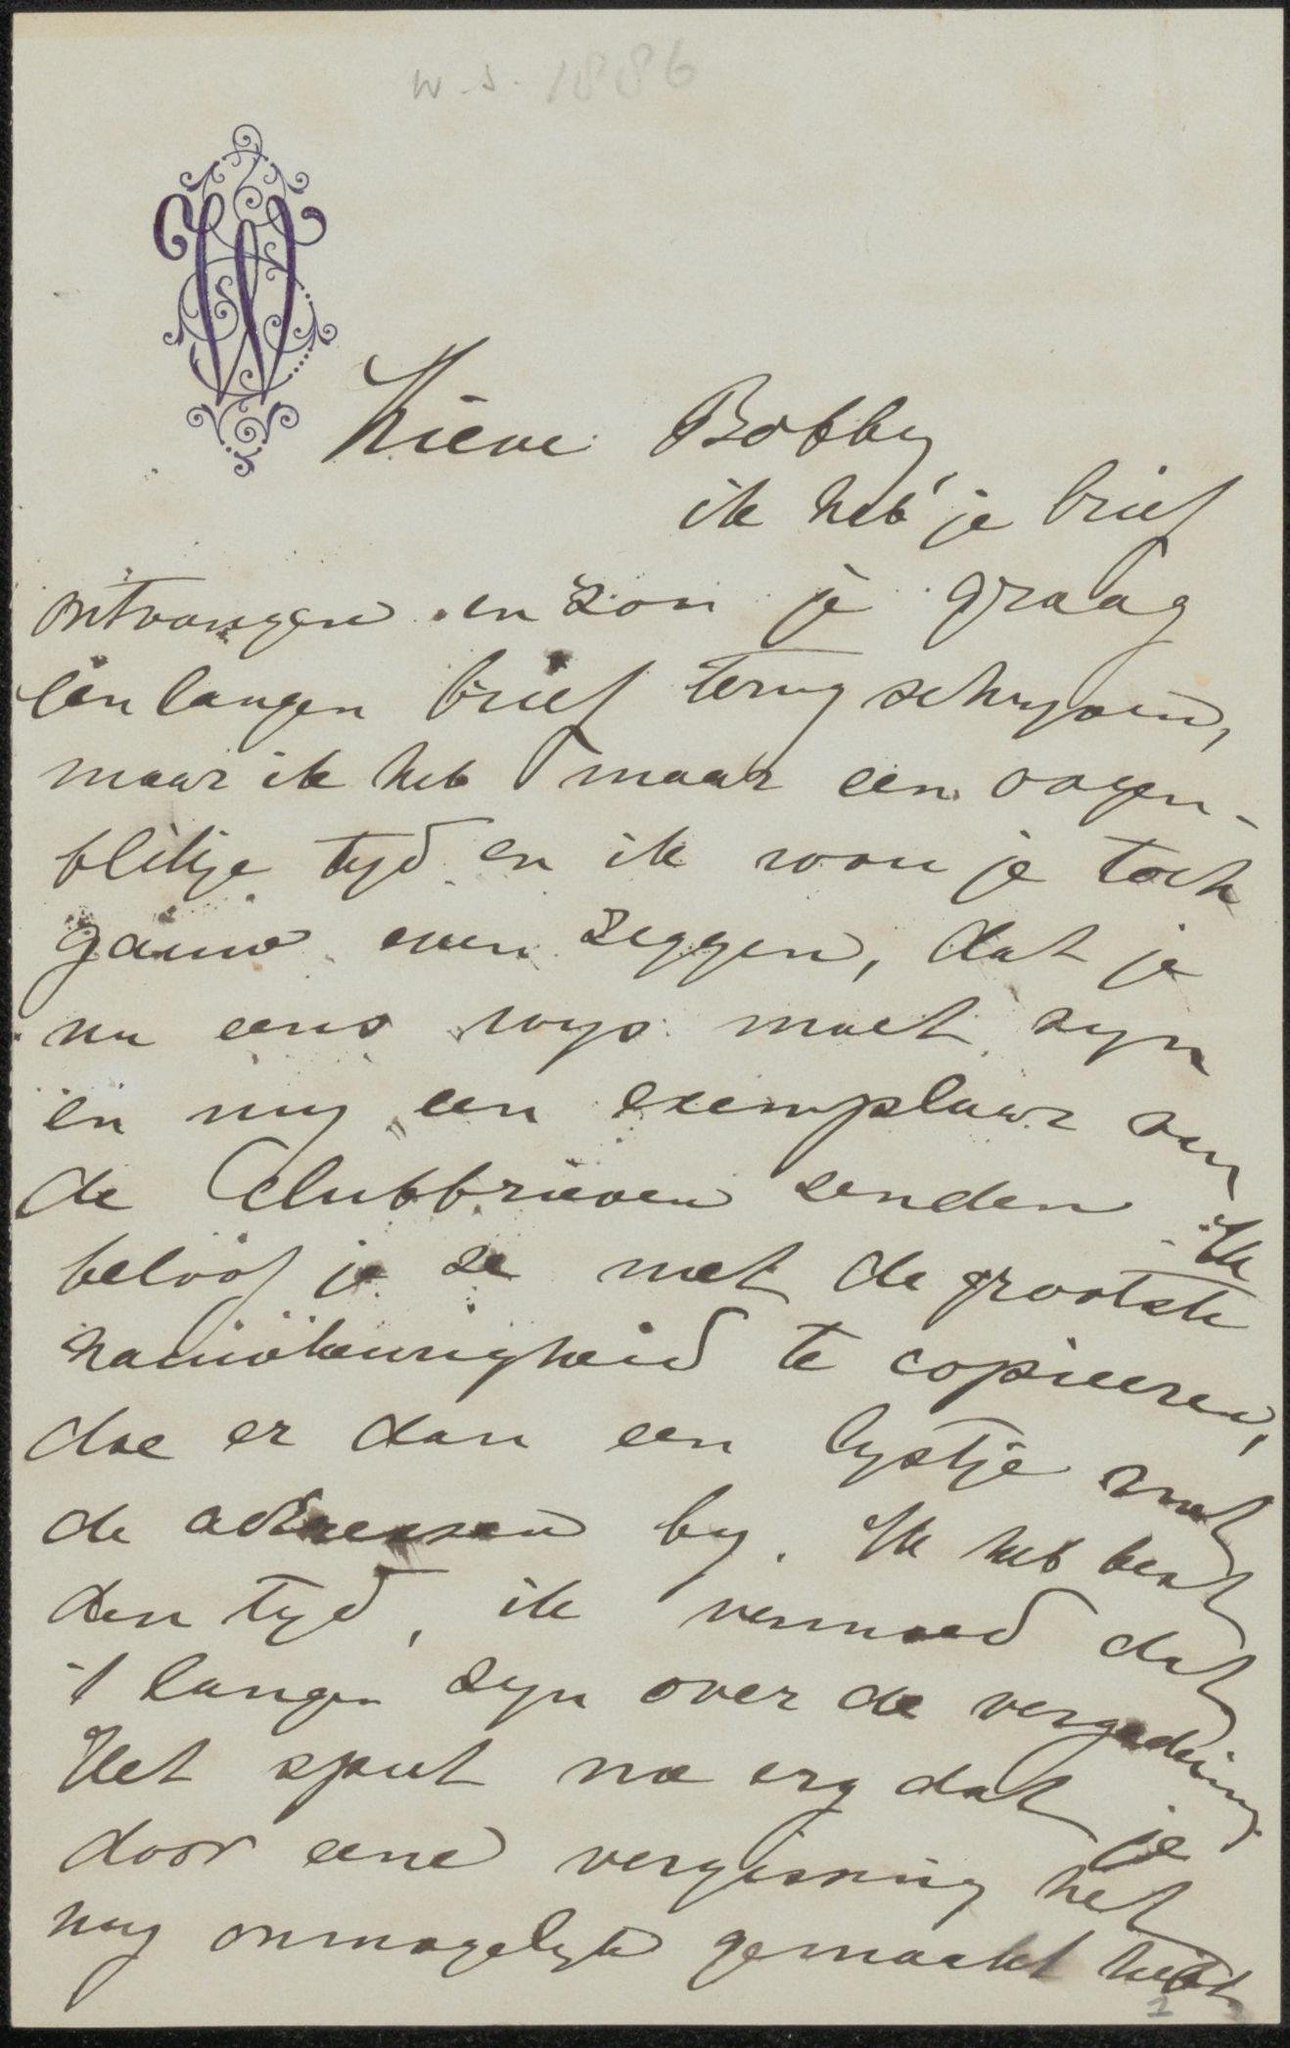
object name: letter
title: Brief aan Jan Veth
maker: wally moes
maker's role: draughtsman, print maker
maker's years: 1856-1918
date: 1866-1918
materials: ink, paper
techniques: pen, writing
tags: dordrecht, jan veth, arnhem, anton mauve, amsterdam, painter, print maker, draughtsman, willem witsen, utrecht, etha fles, criticizing and discussing art, art criticism, drawing, the graphic arts, painting (including book-illumination, miniature-painting), exhibition ~ art, historical persons (portraits and scenes from the life), the hague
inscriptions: collector's mark: ‘RPK’, initials